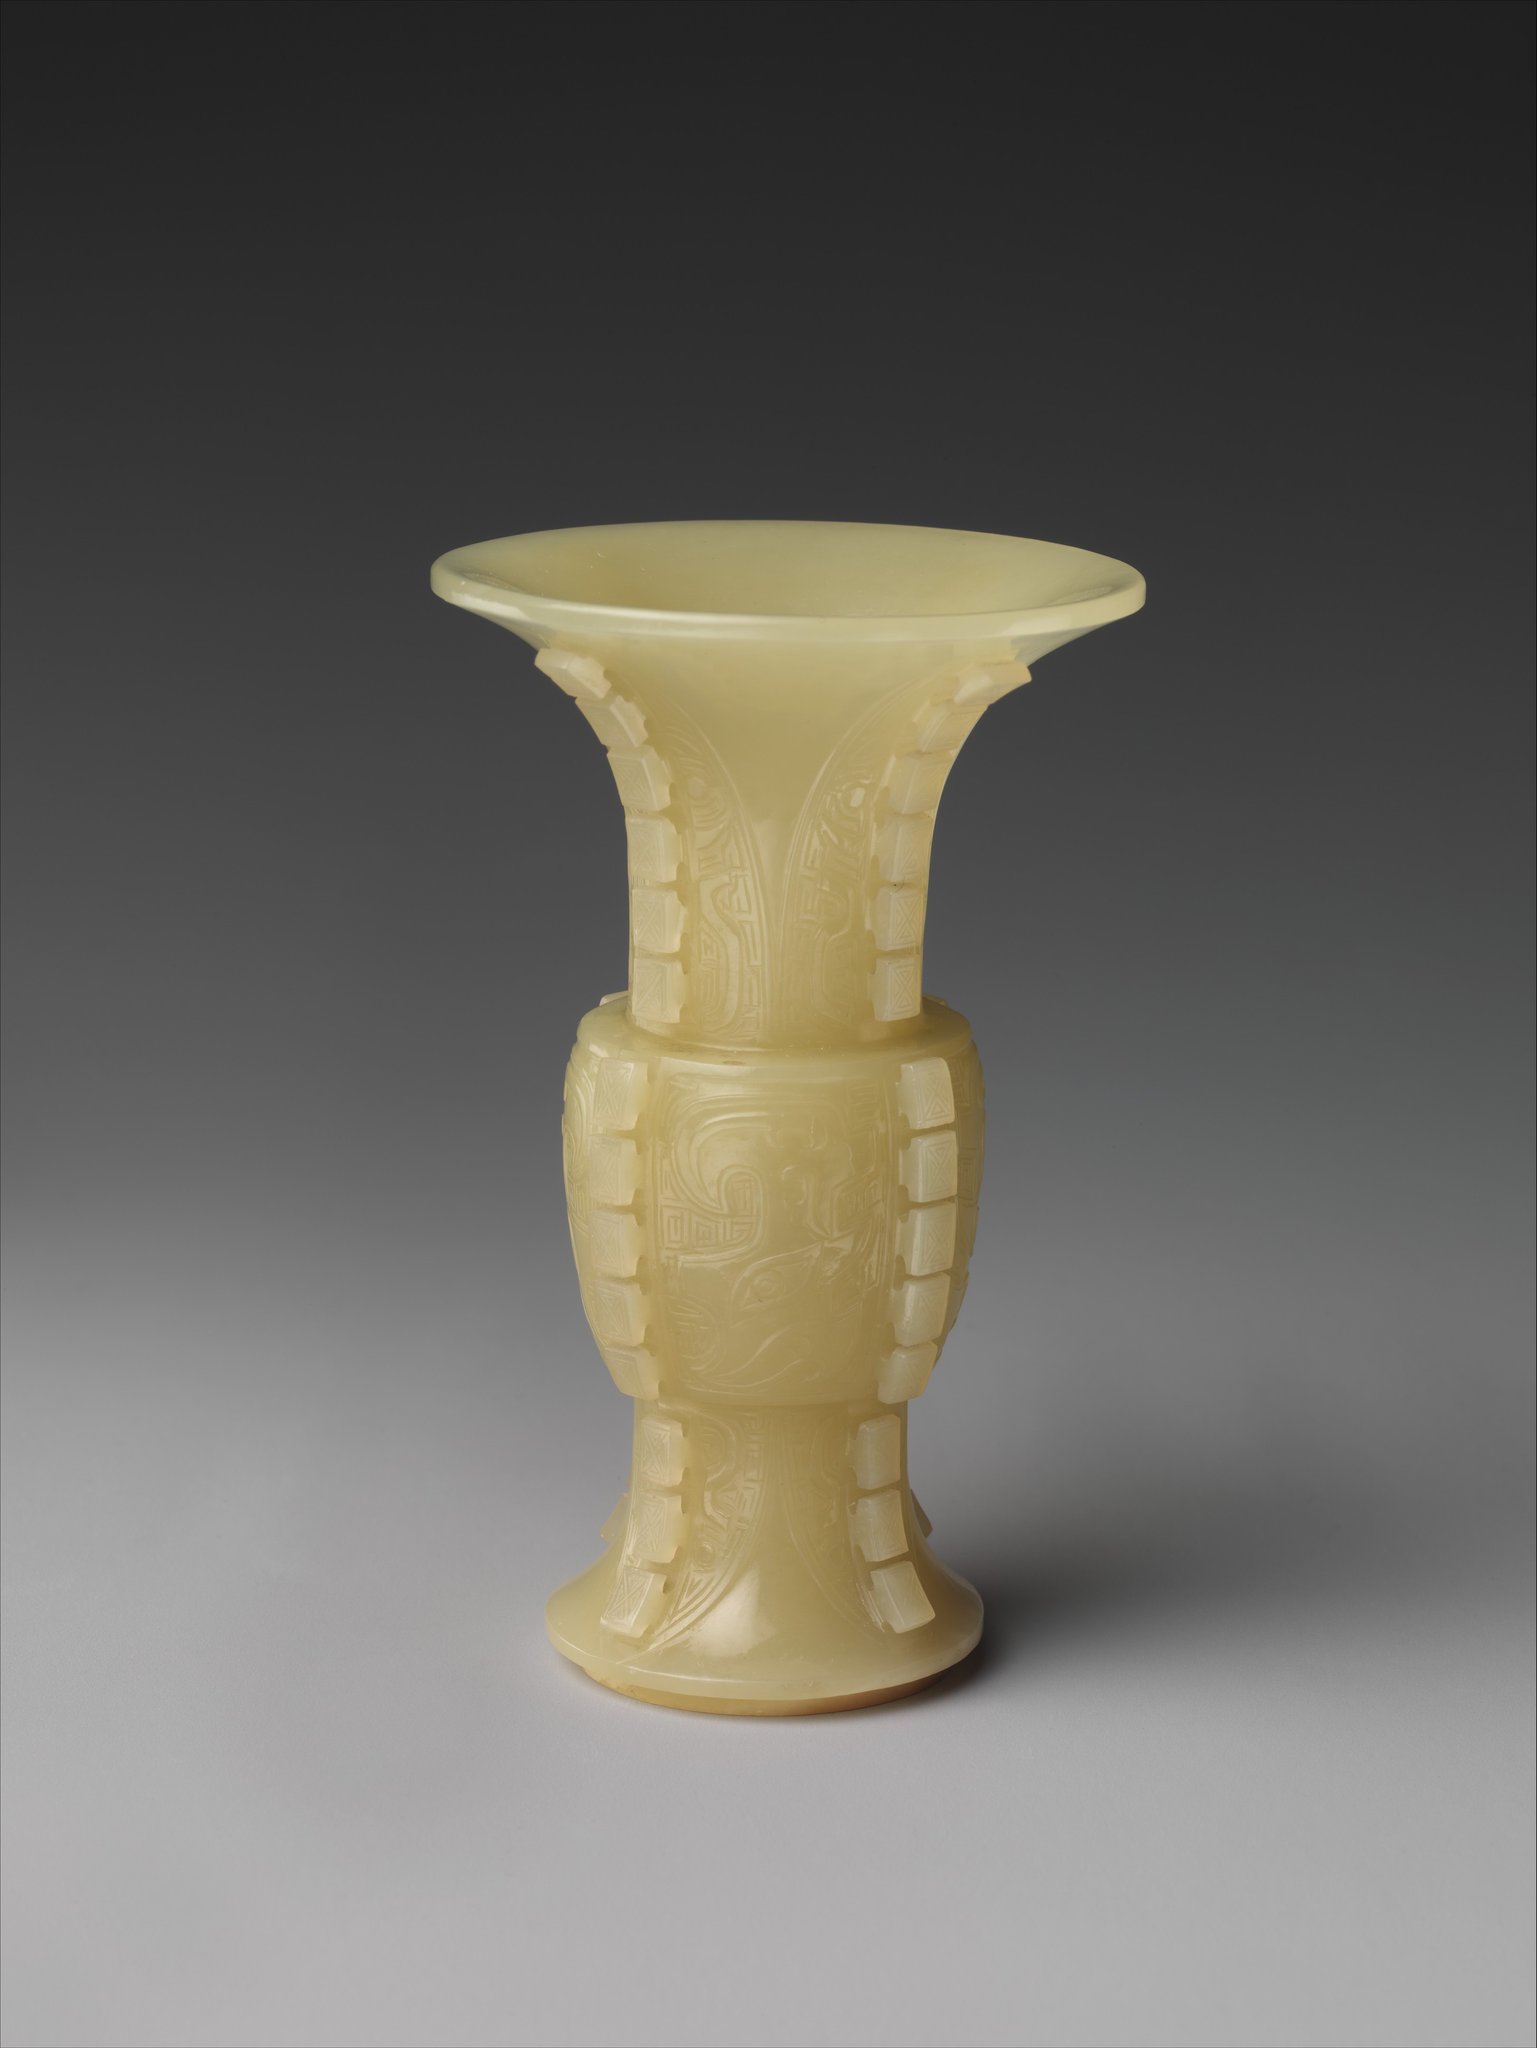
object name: vase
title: Miniature vase in the shape of an ancient ritual vessel (gu)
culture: chinese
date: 1767-1833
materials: jade